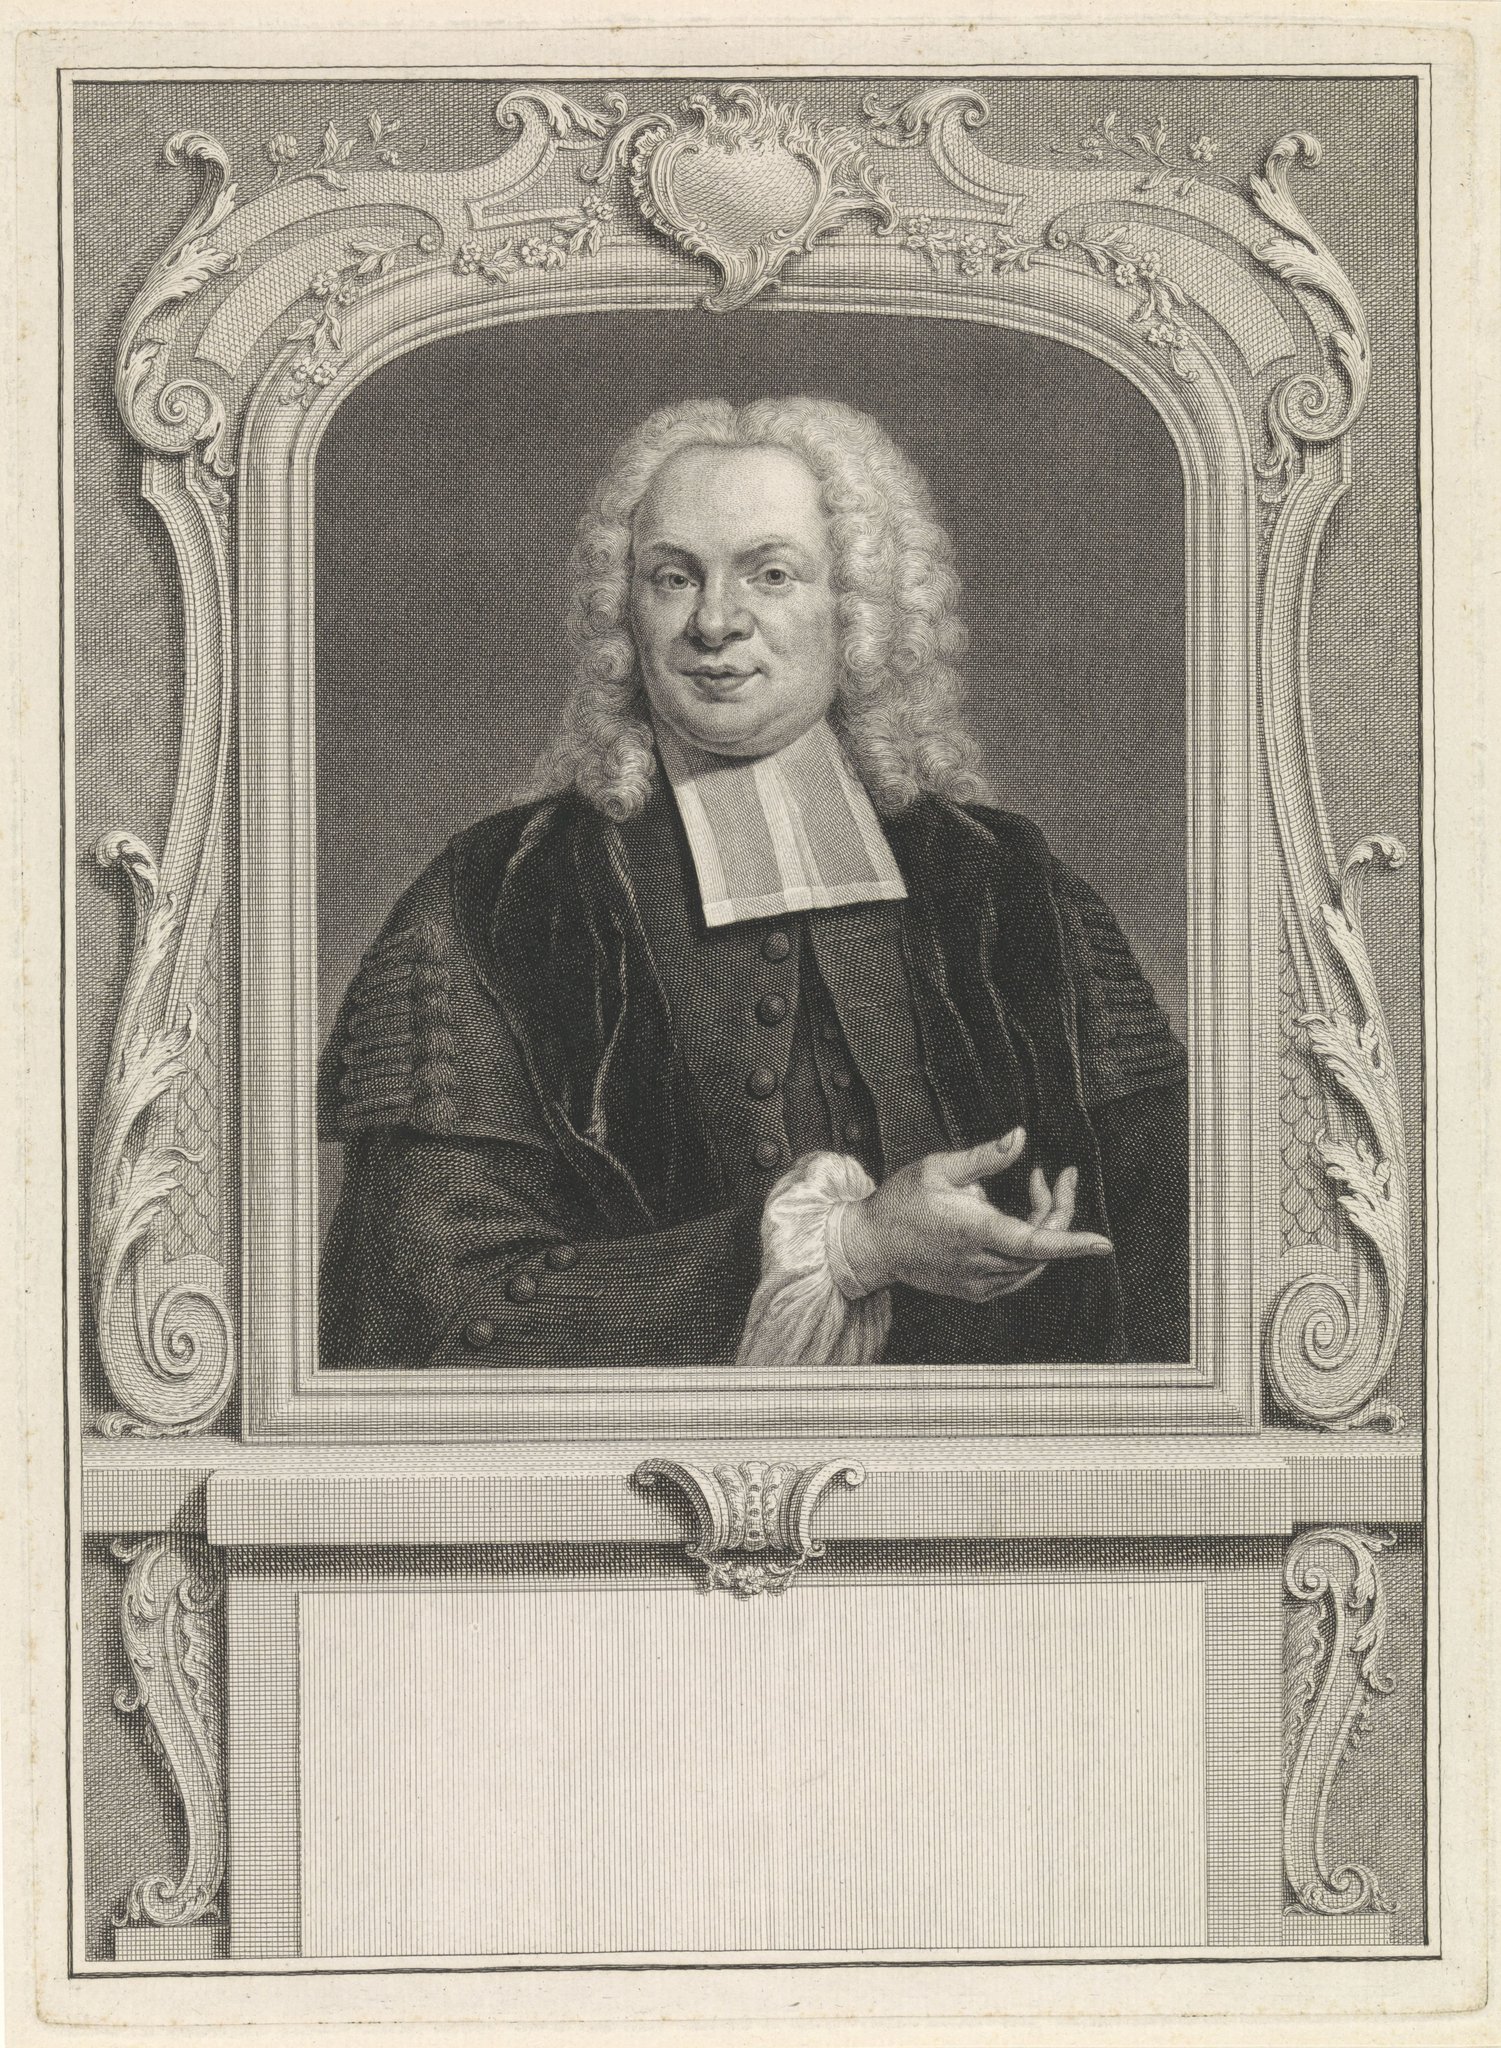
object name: print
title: Portret van Albertus Voget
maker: pieter tanjé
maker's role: draughtsman, print maker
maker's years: 1706-1761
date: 1716-1761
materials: paper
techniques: engraving, etching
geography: amsterdam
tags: albertus voget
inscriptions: collector's mark: Lugt 240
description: Portret van Albertus Voget, predikant en hoogleraar in de theologie, in een ornamentele lijst.